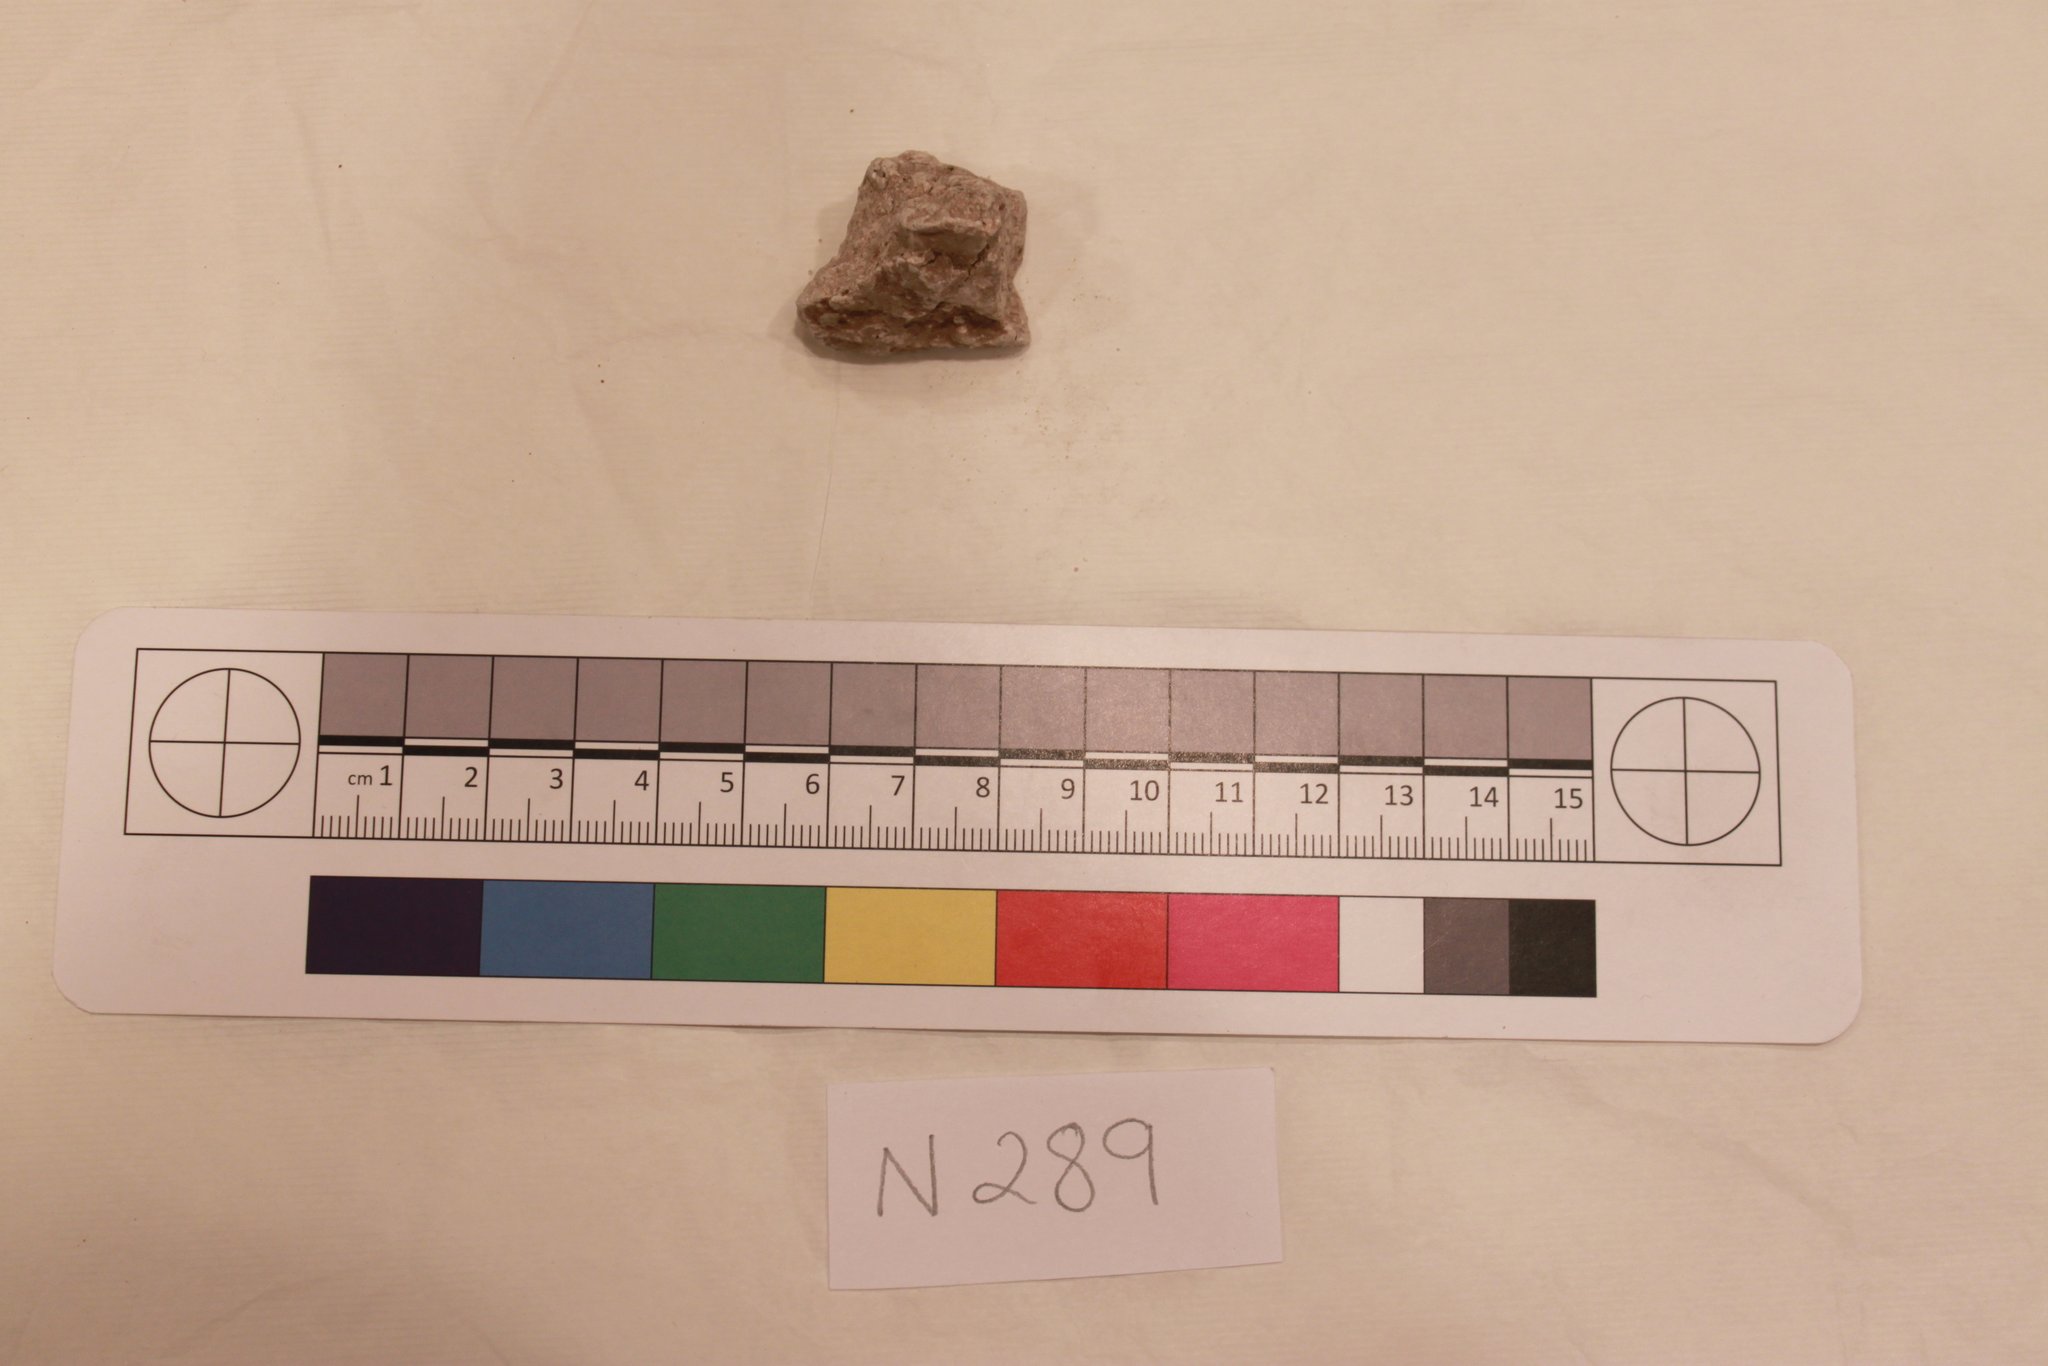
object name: fragment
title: Stucco Fragment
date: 701-1200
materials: plaster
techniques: carving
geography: iran